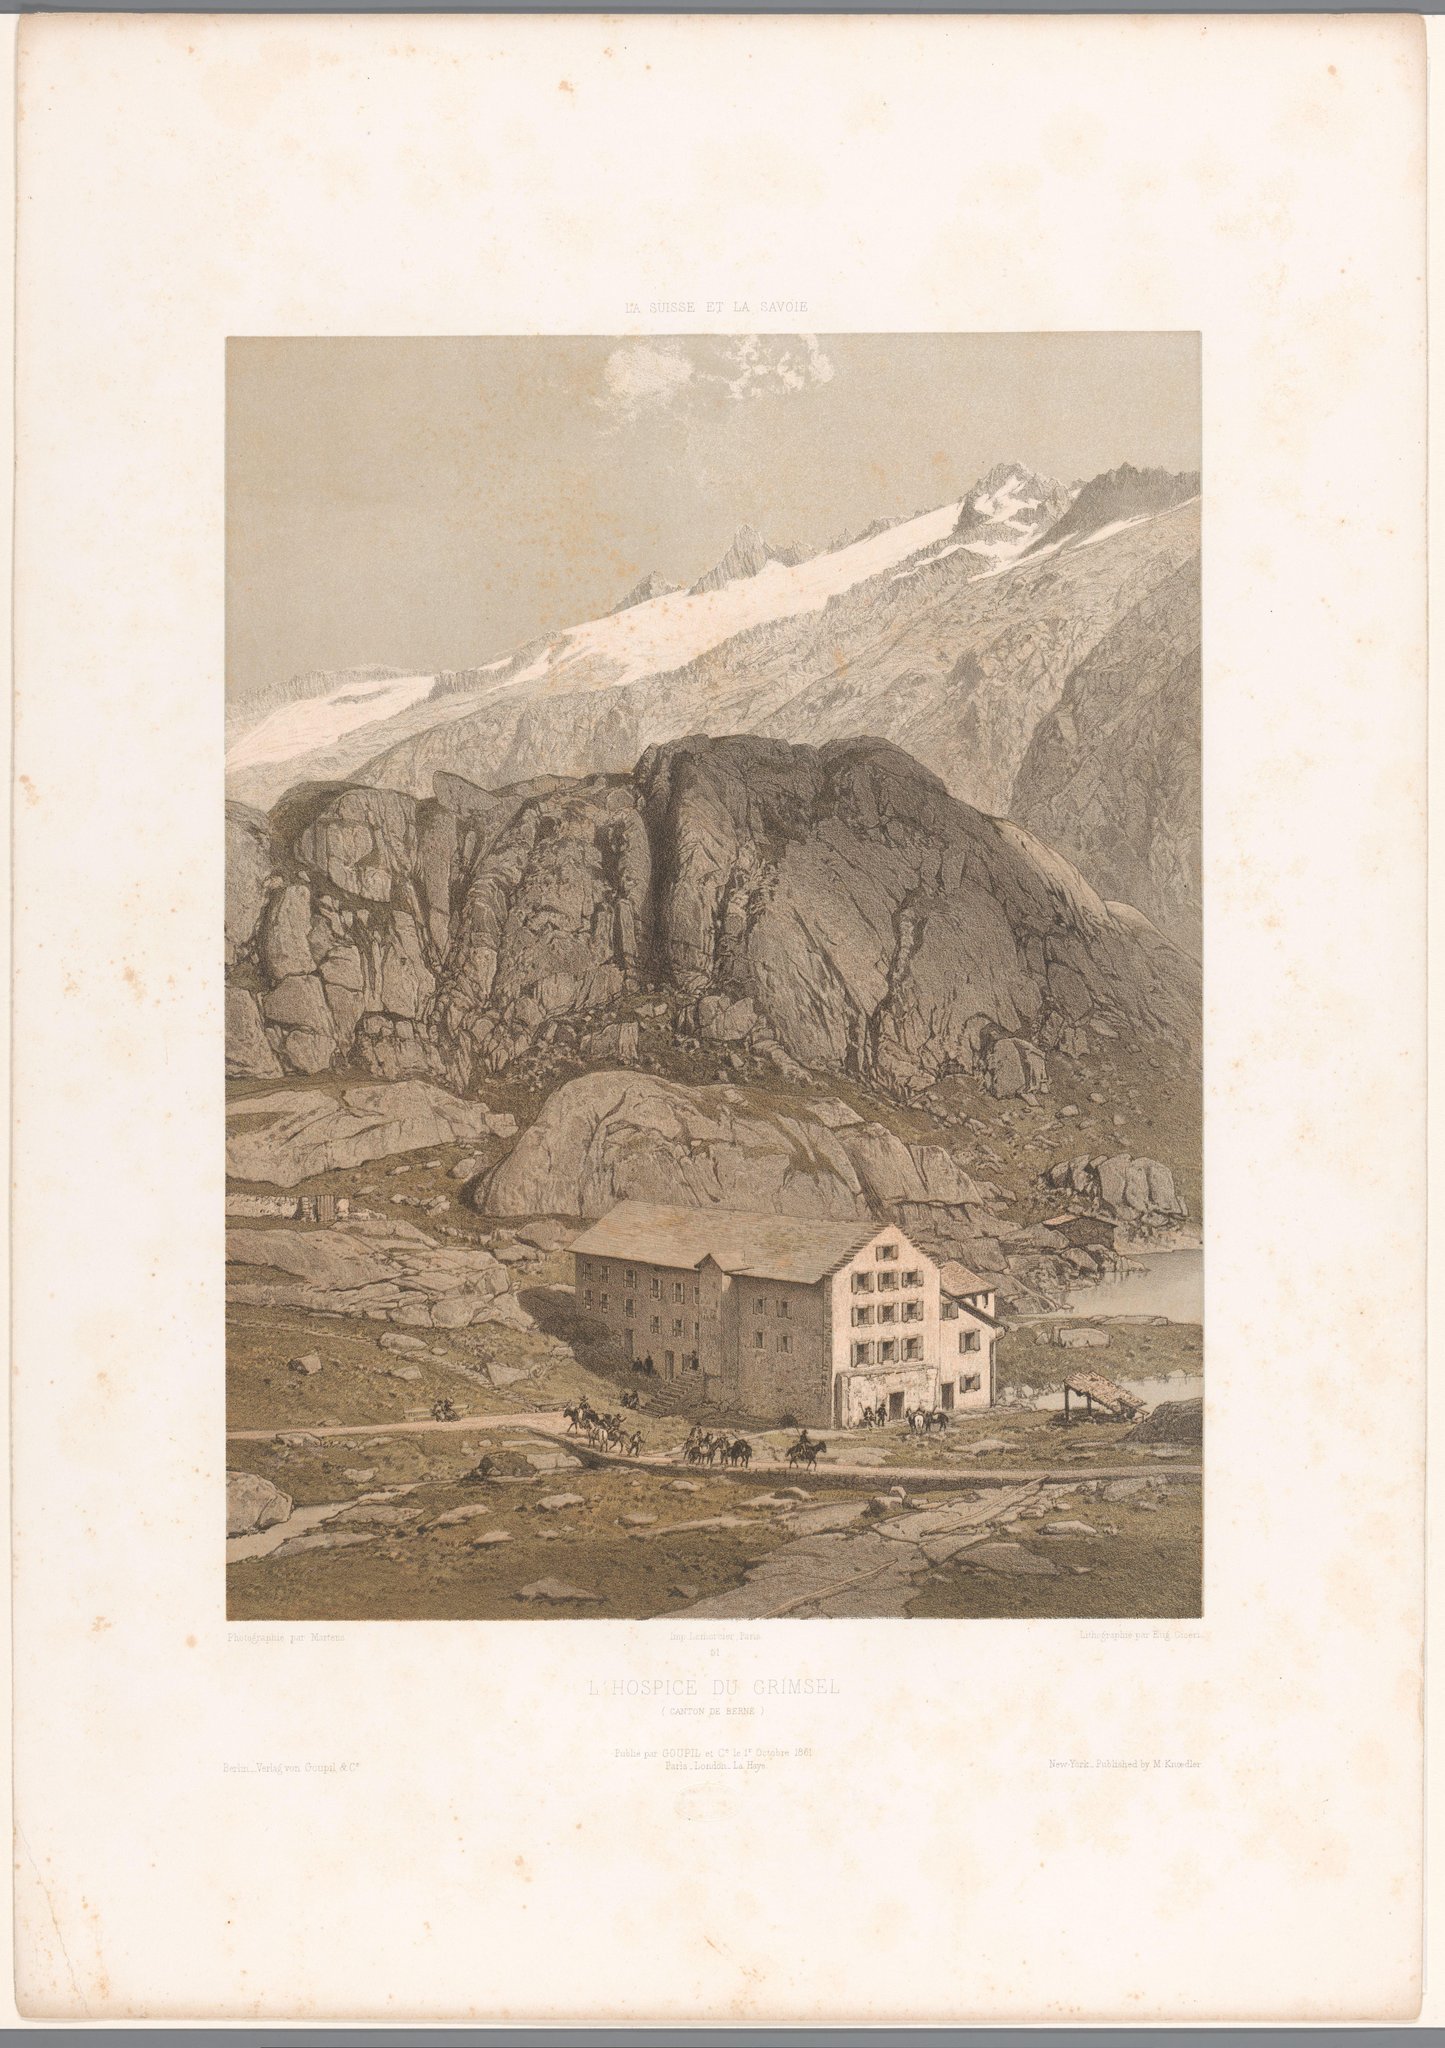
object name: print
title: Gezichten in Zwitserland en Savoye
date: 1859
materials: paper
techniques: lithograph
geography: paris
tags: mountain-range, snow peaks (+ landscape with figures, staffage), road, path, hotel, hostelry, inn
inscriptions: check stamp: Lugt 1090